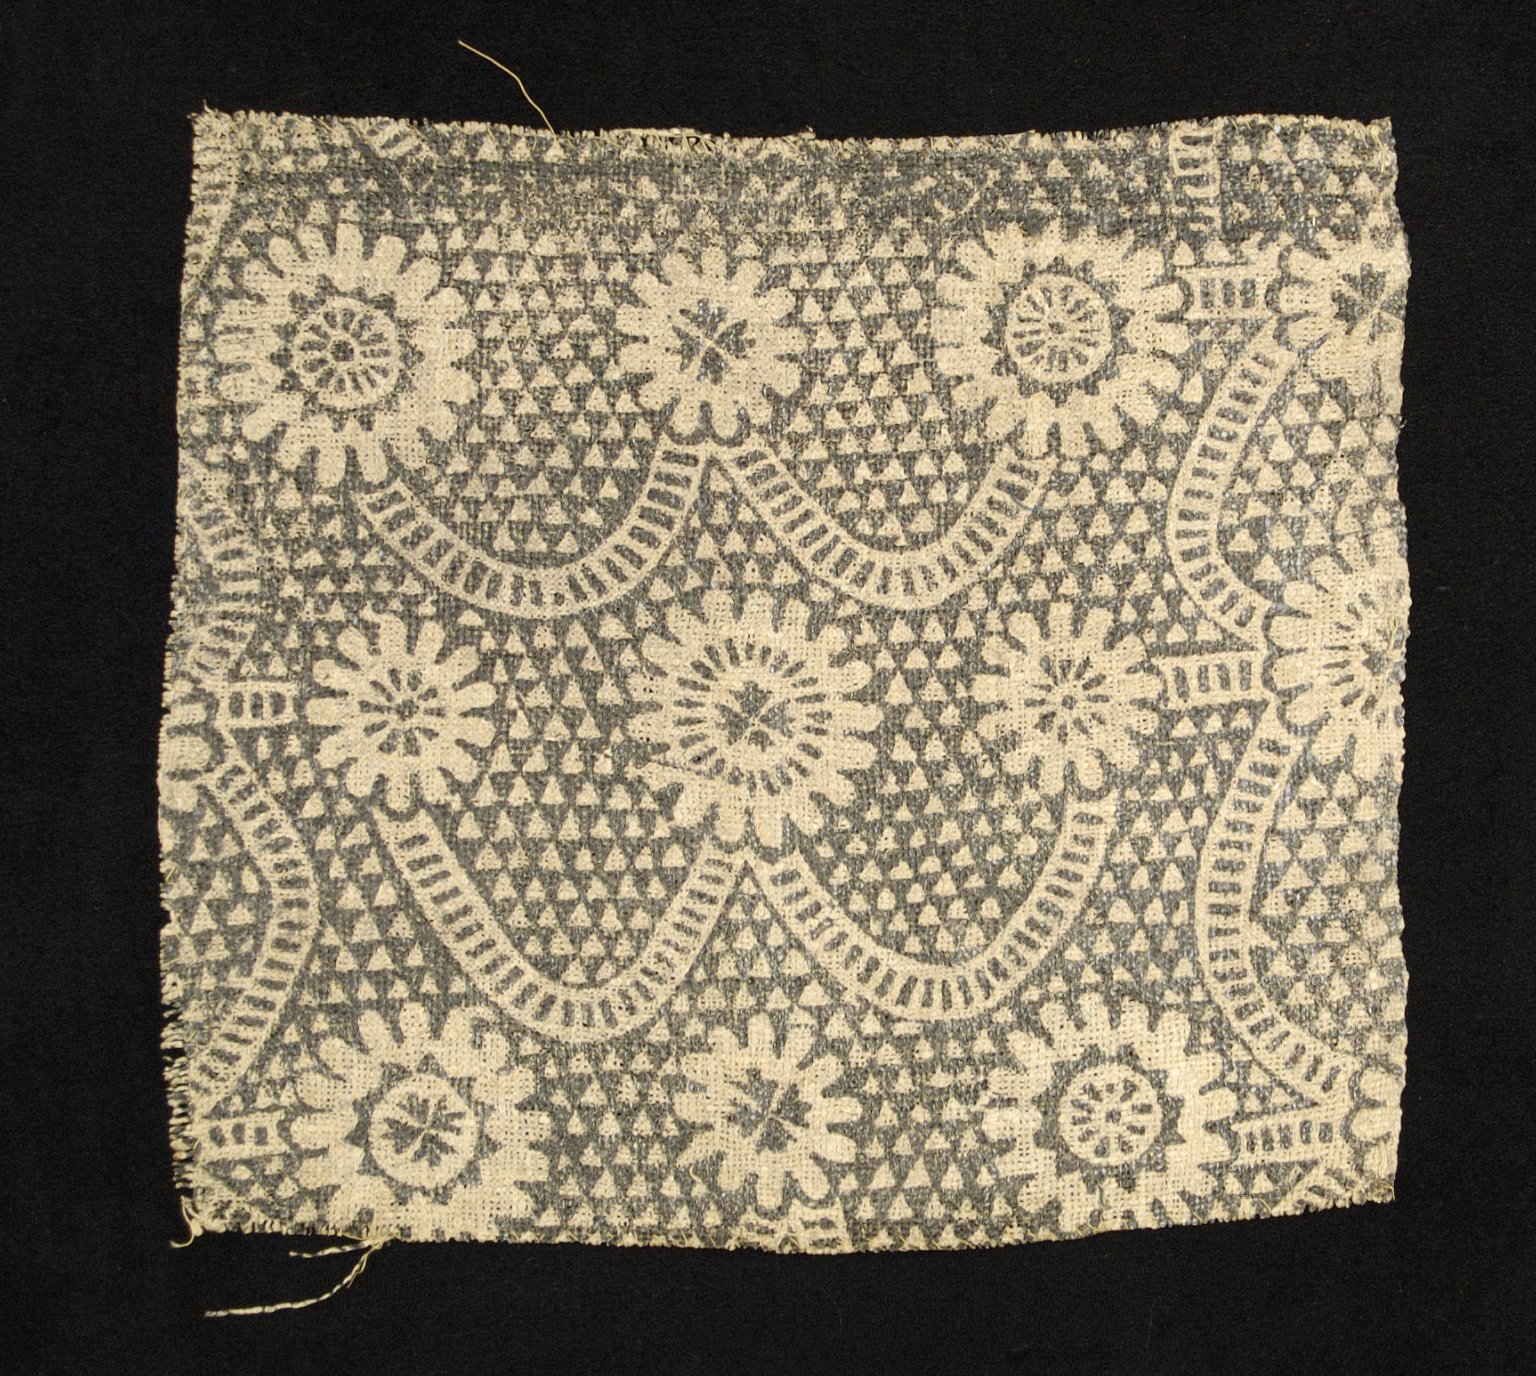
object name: textile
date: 1700-1899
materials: linen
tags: flowers